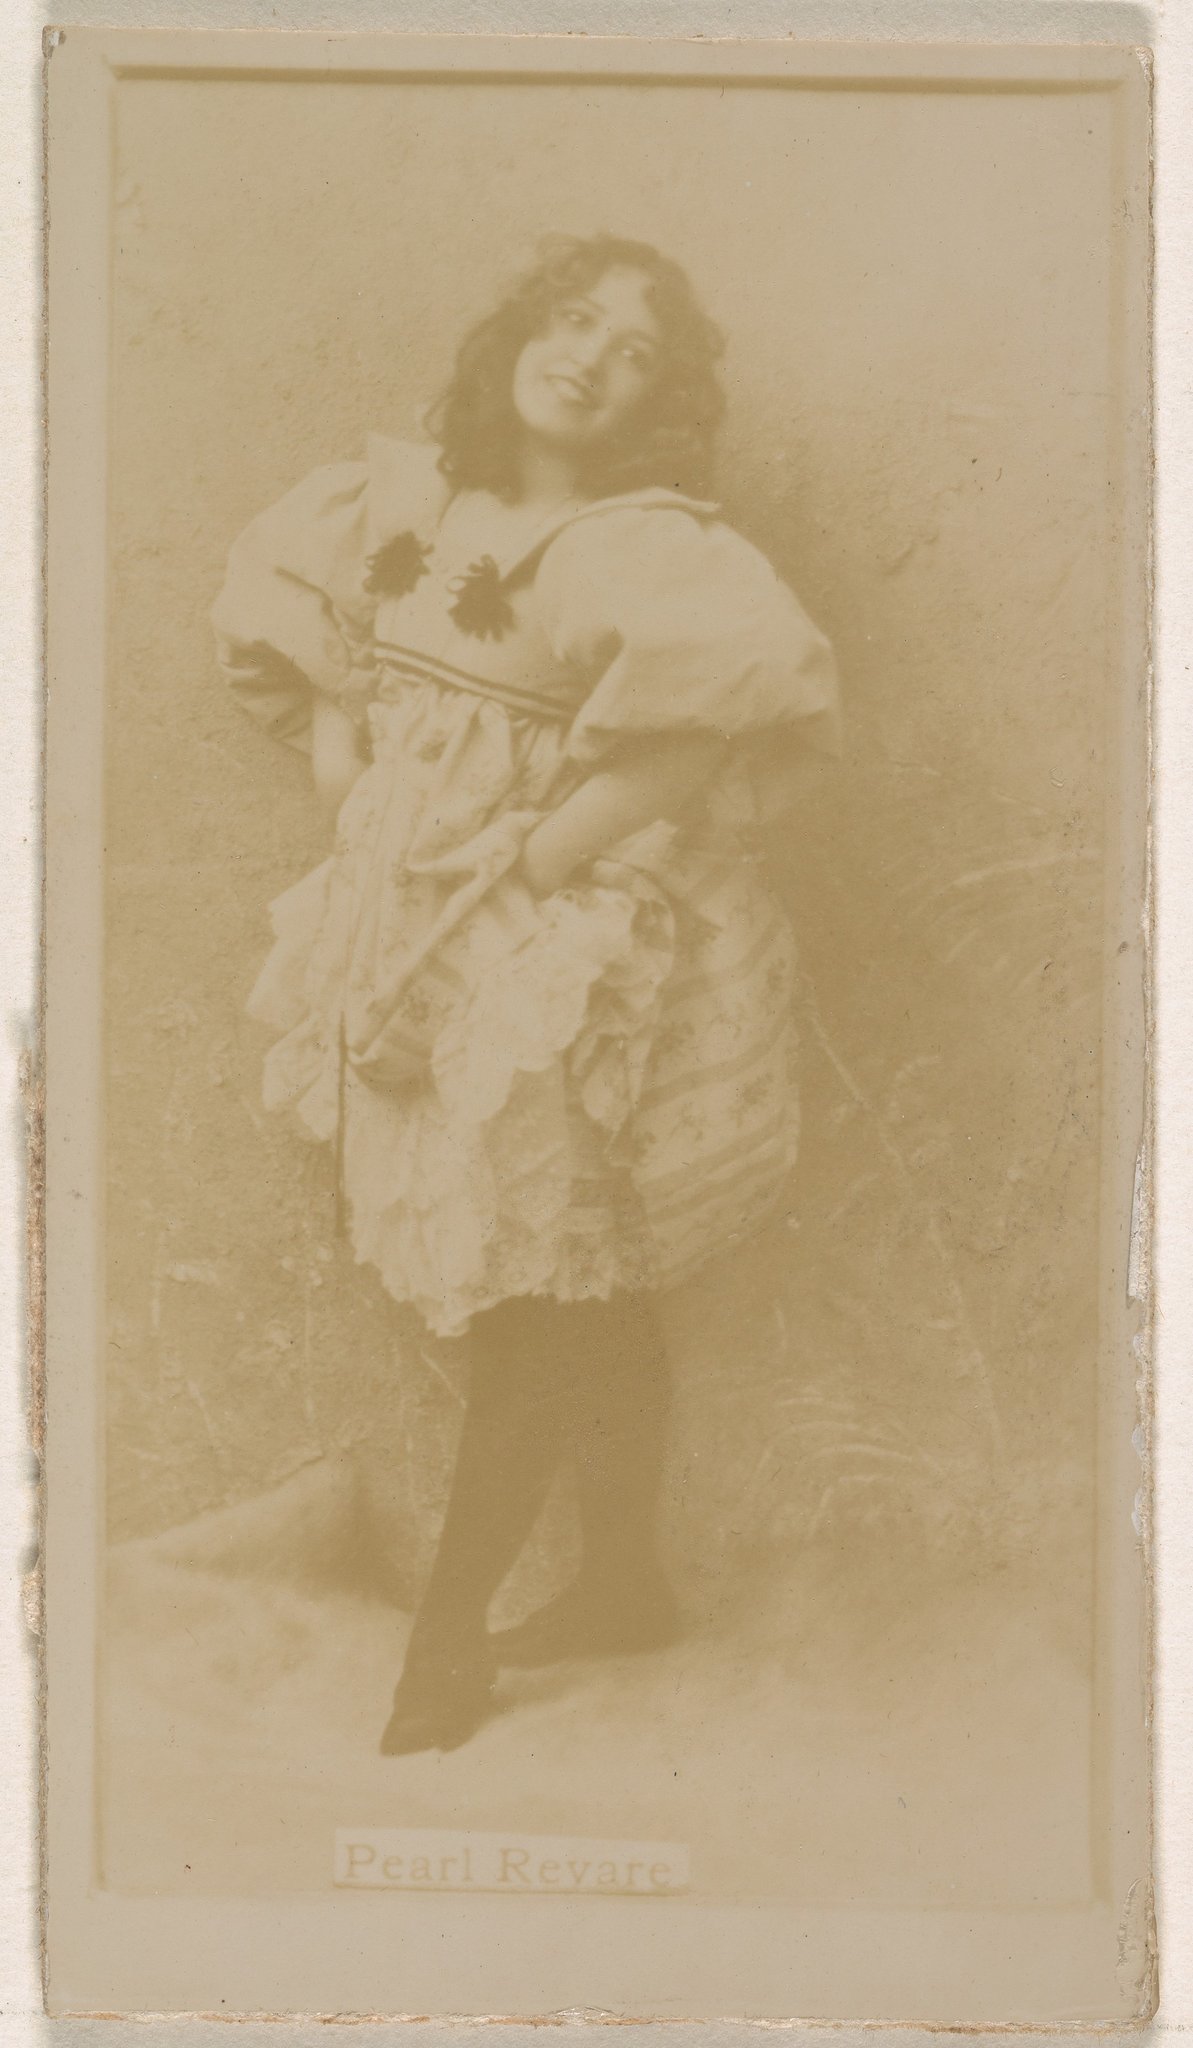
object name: photograph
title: Pearl Revare, from the Actresses series (N245) issued by Kinney Brothers to promote Sweet Caporal Cigarettes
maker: kinney brothers tobacco company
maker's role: publisher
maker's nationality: american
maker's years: 1869-2011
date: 1890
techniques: albumen silver print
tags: portraits,women,actresses